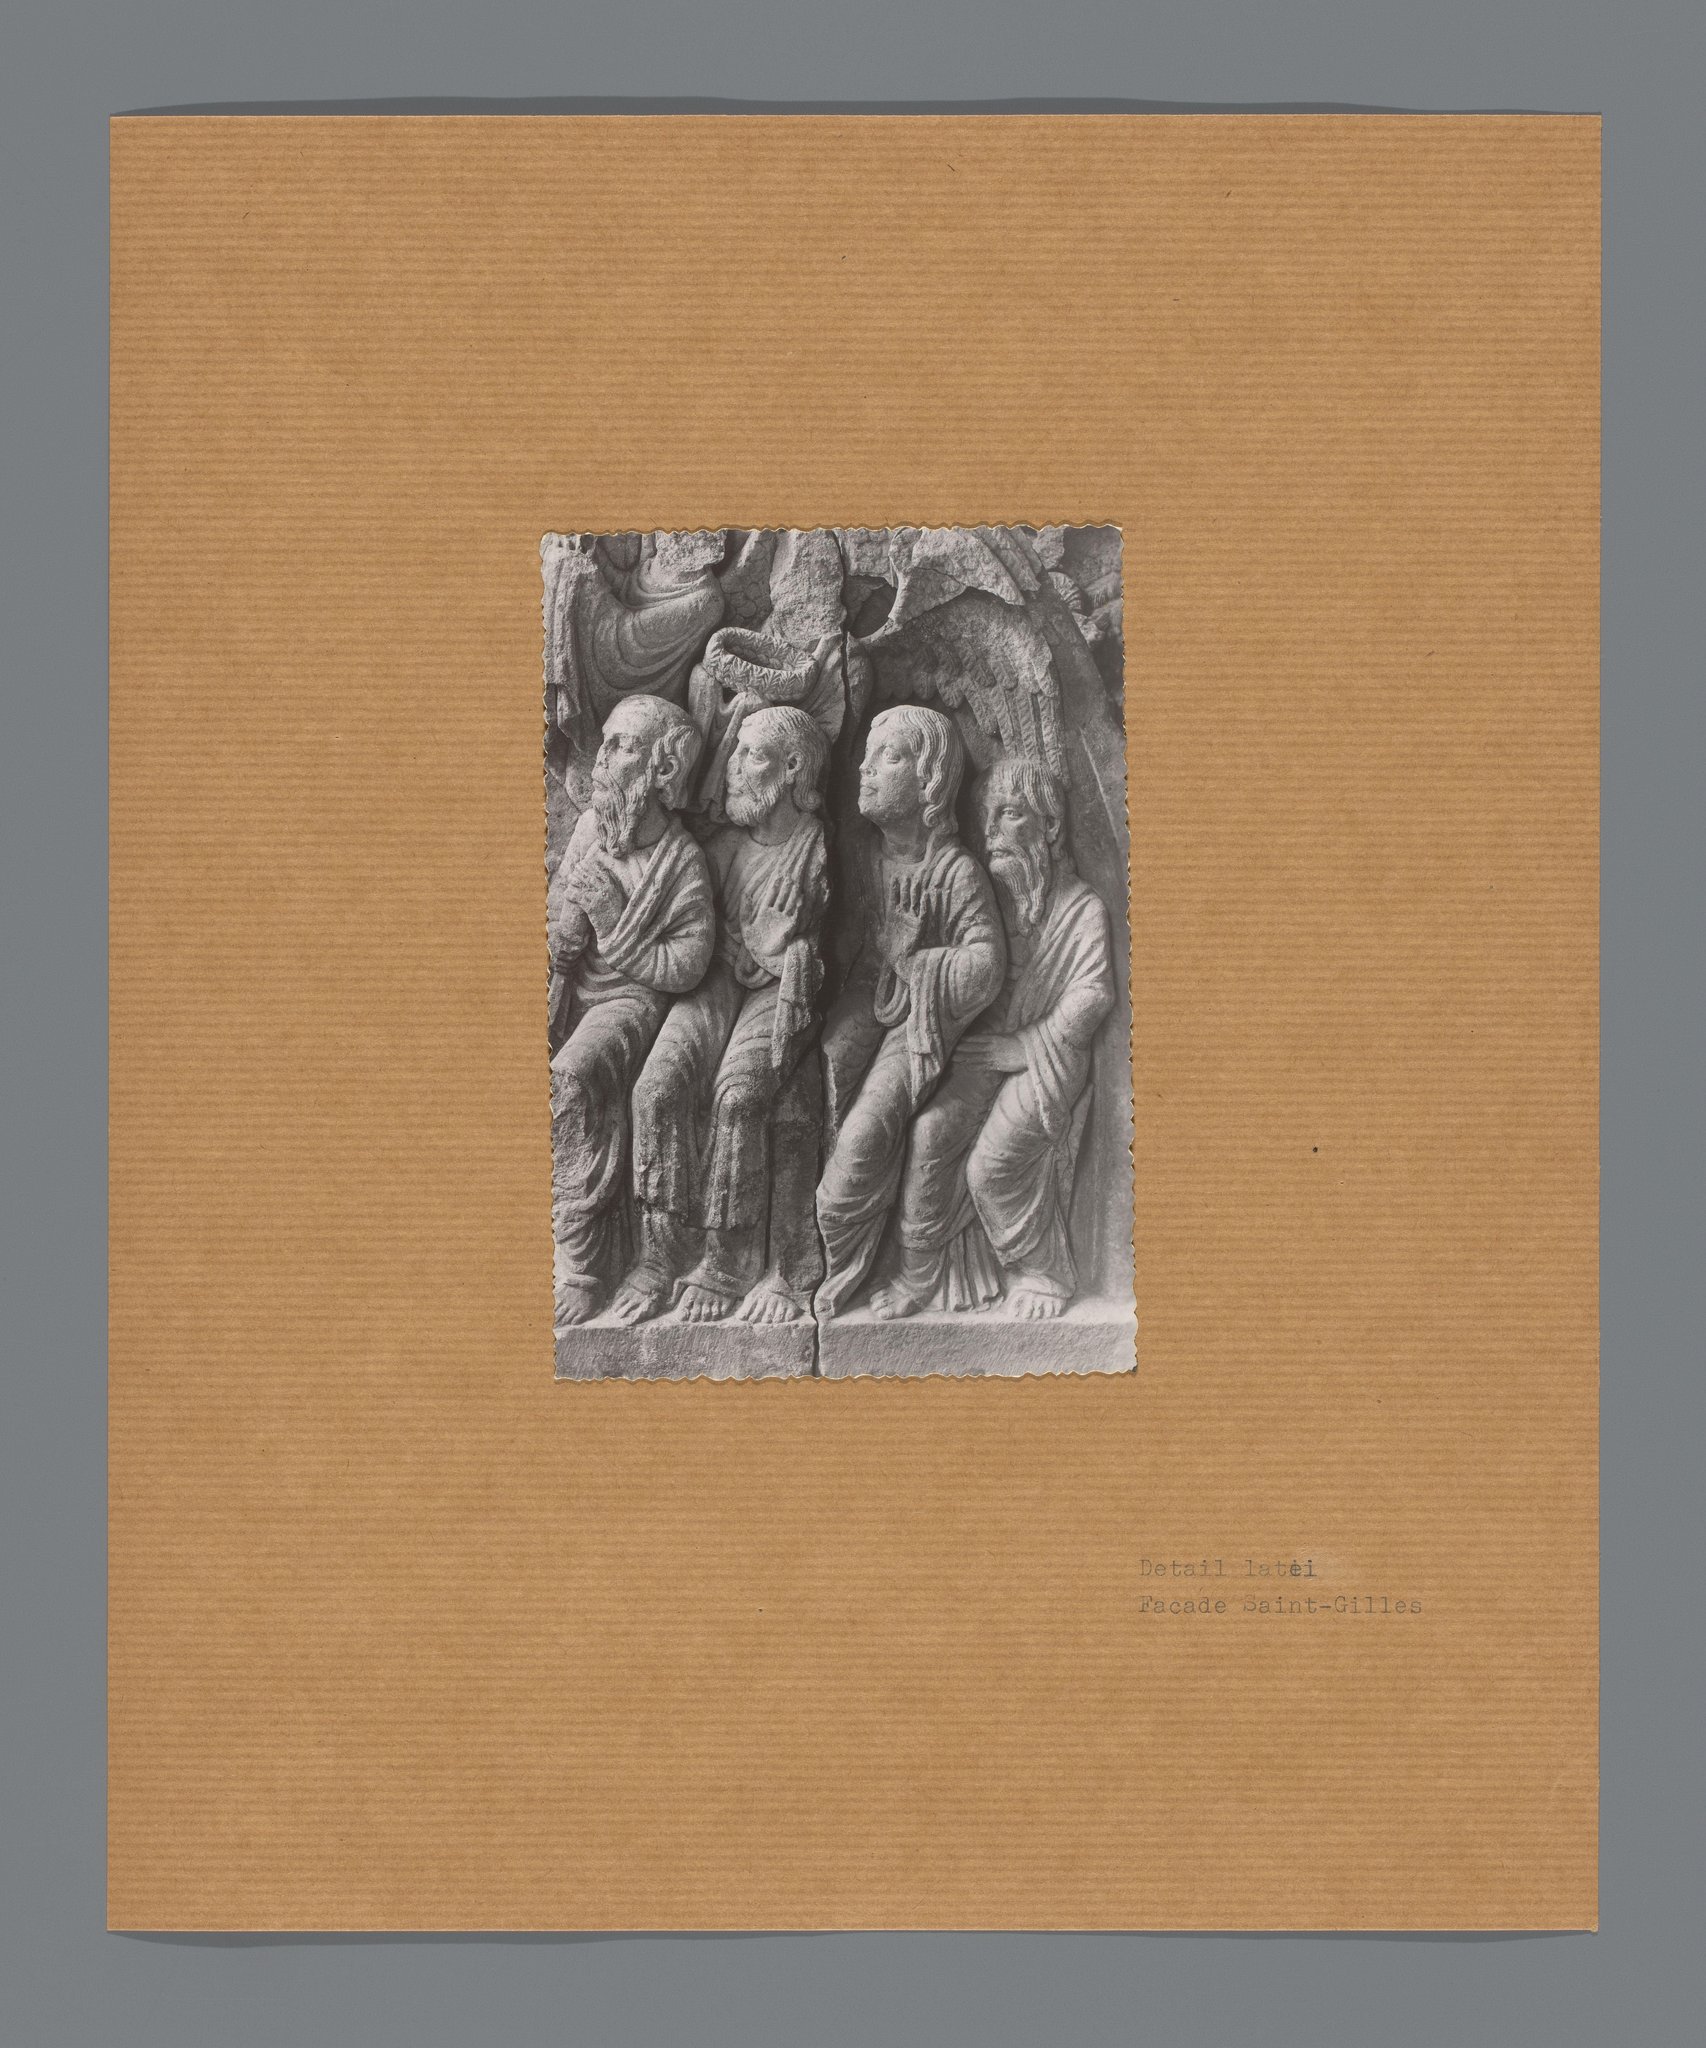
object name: photograph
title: Saint-Gilles, Kirche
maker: Anonymous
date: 1880-1930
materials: photographic support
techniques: gelatin silver print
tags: france